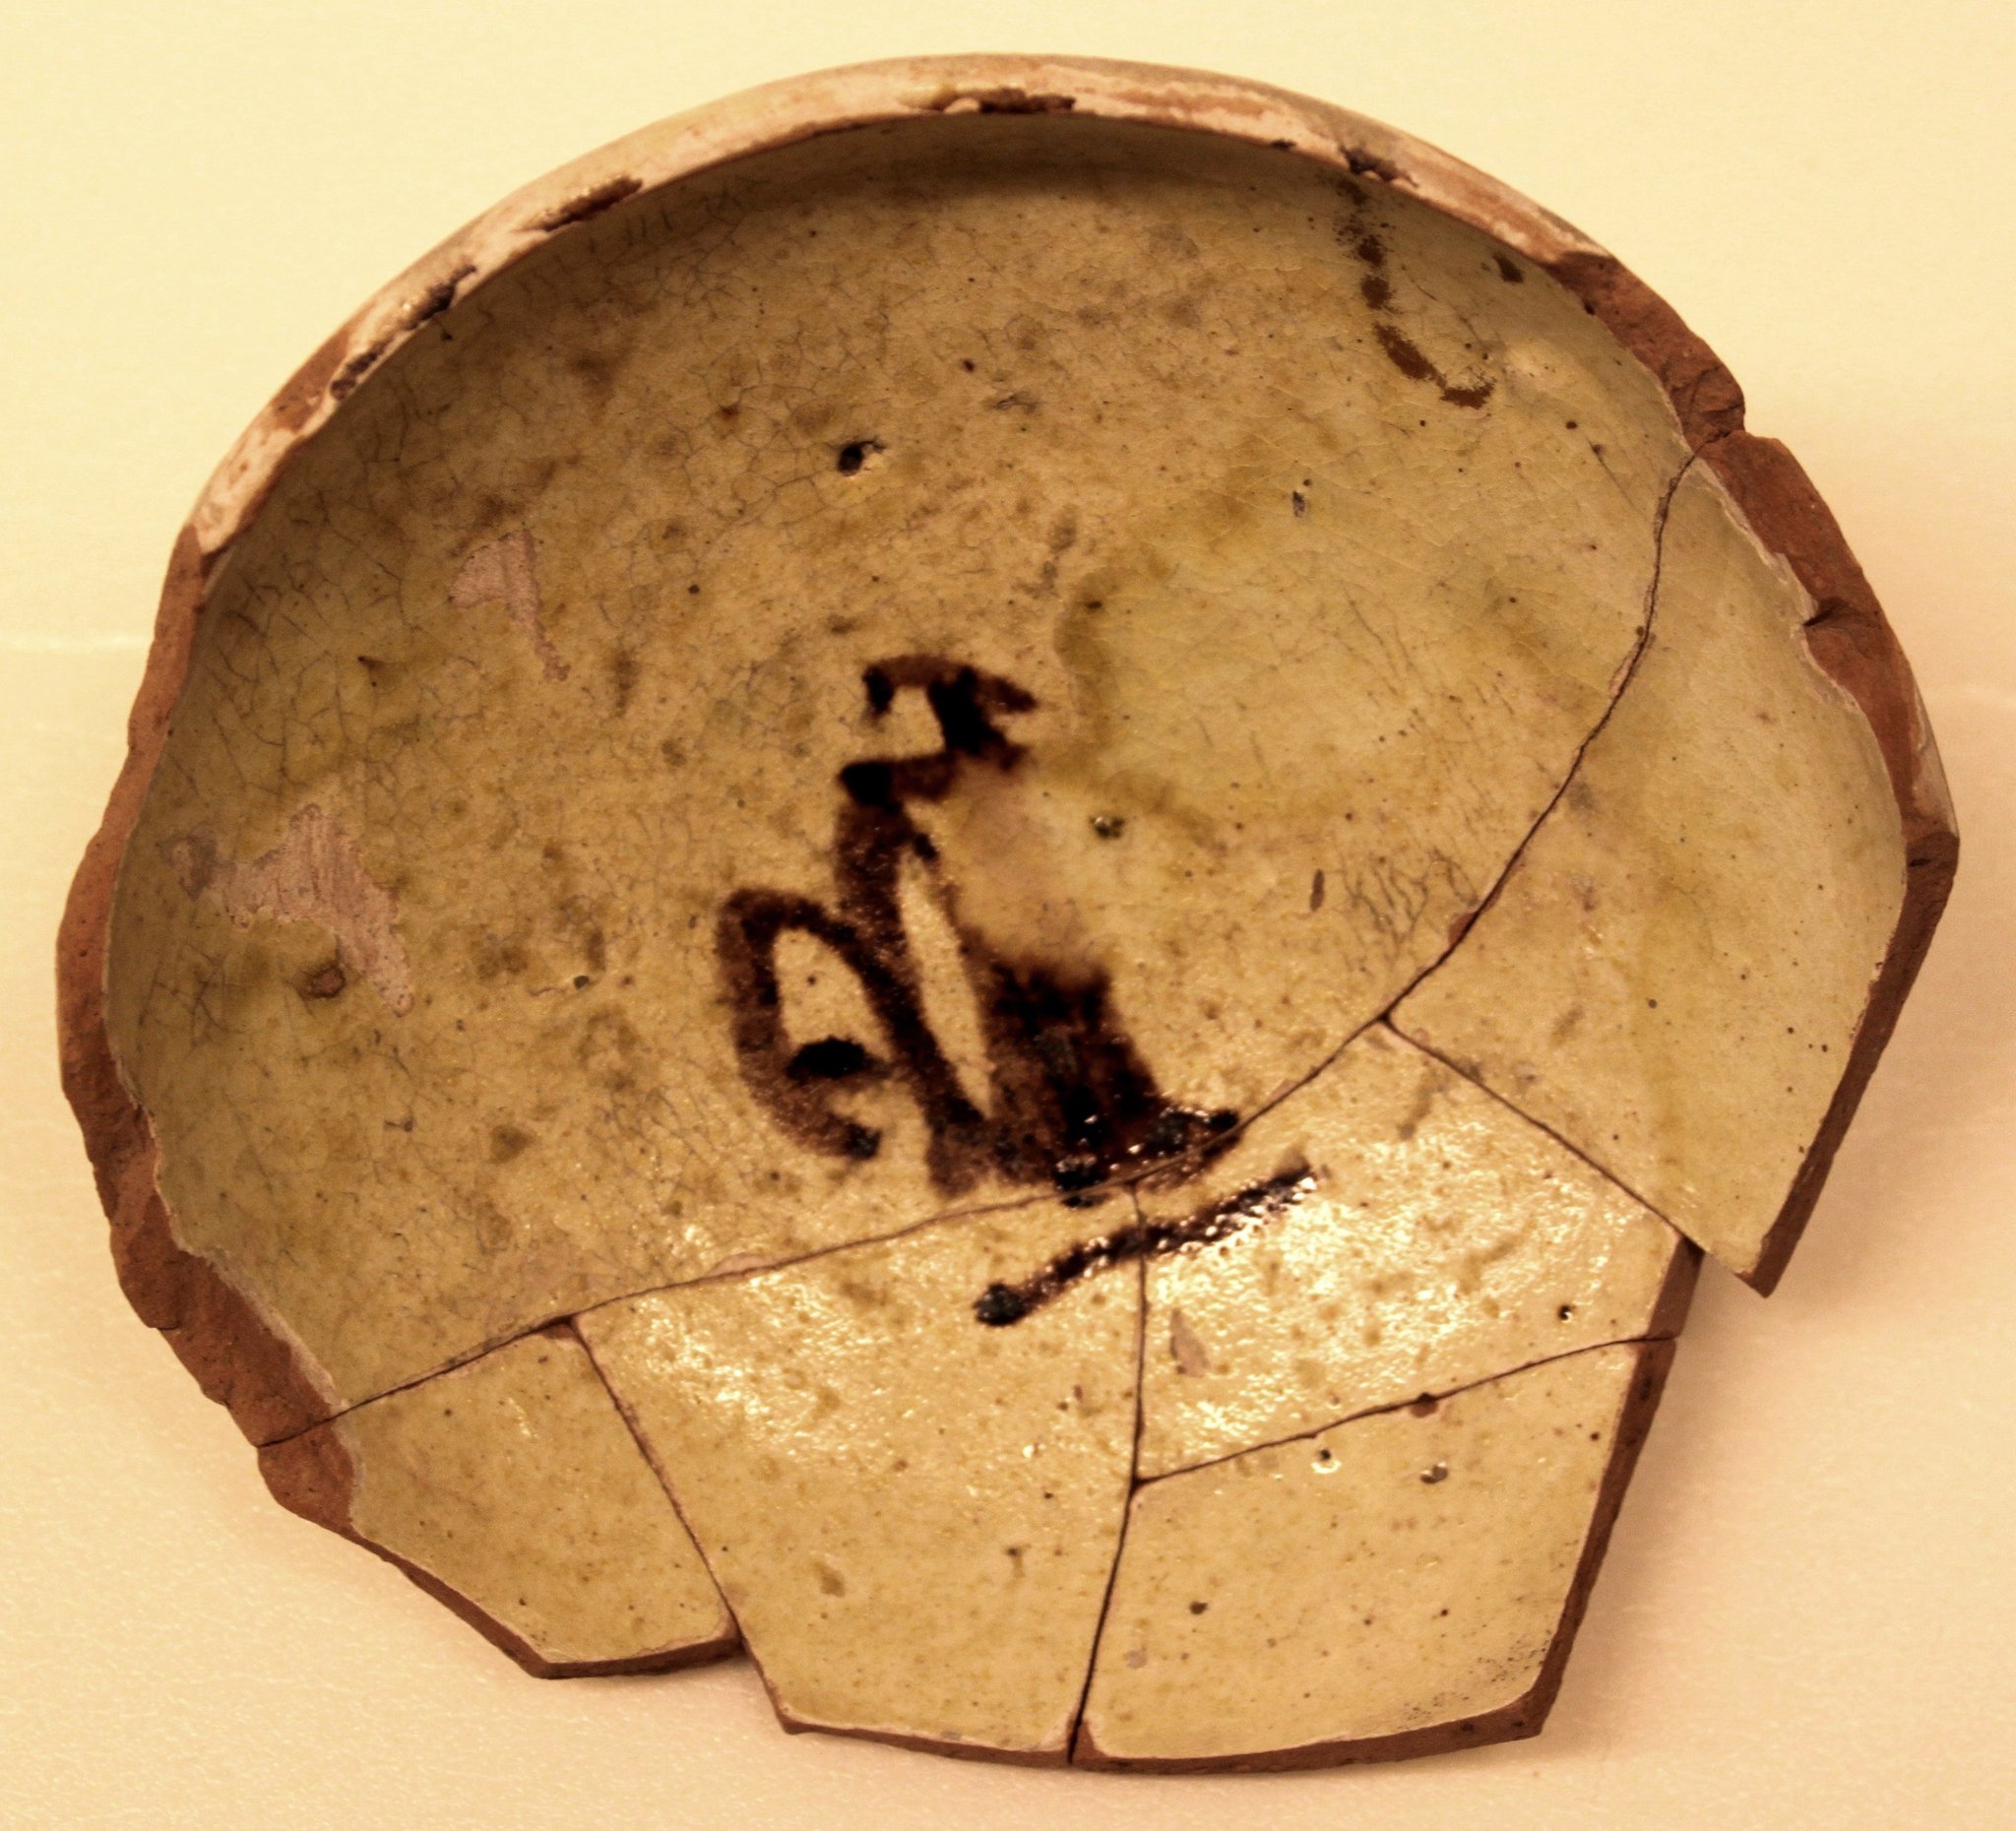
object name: bowl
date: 801-900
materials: earthenware, glaze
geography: iran